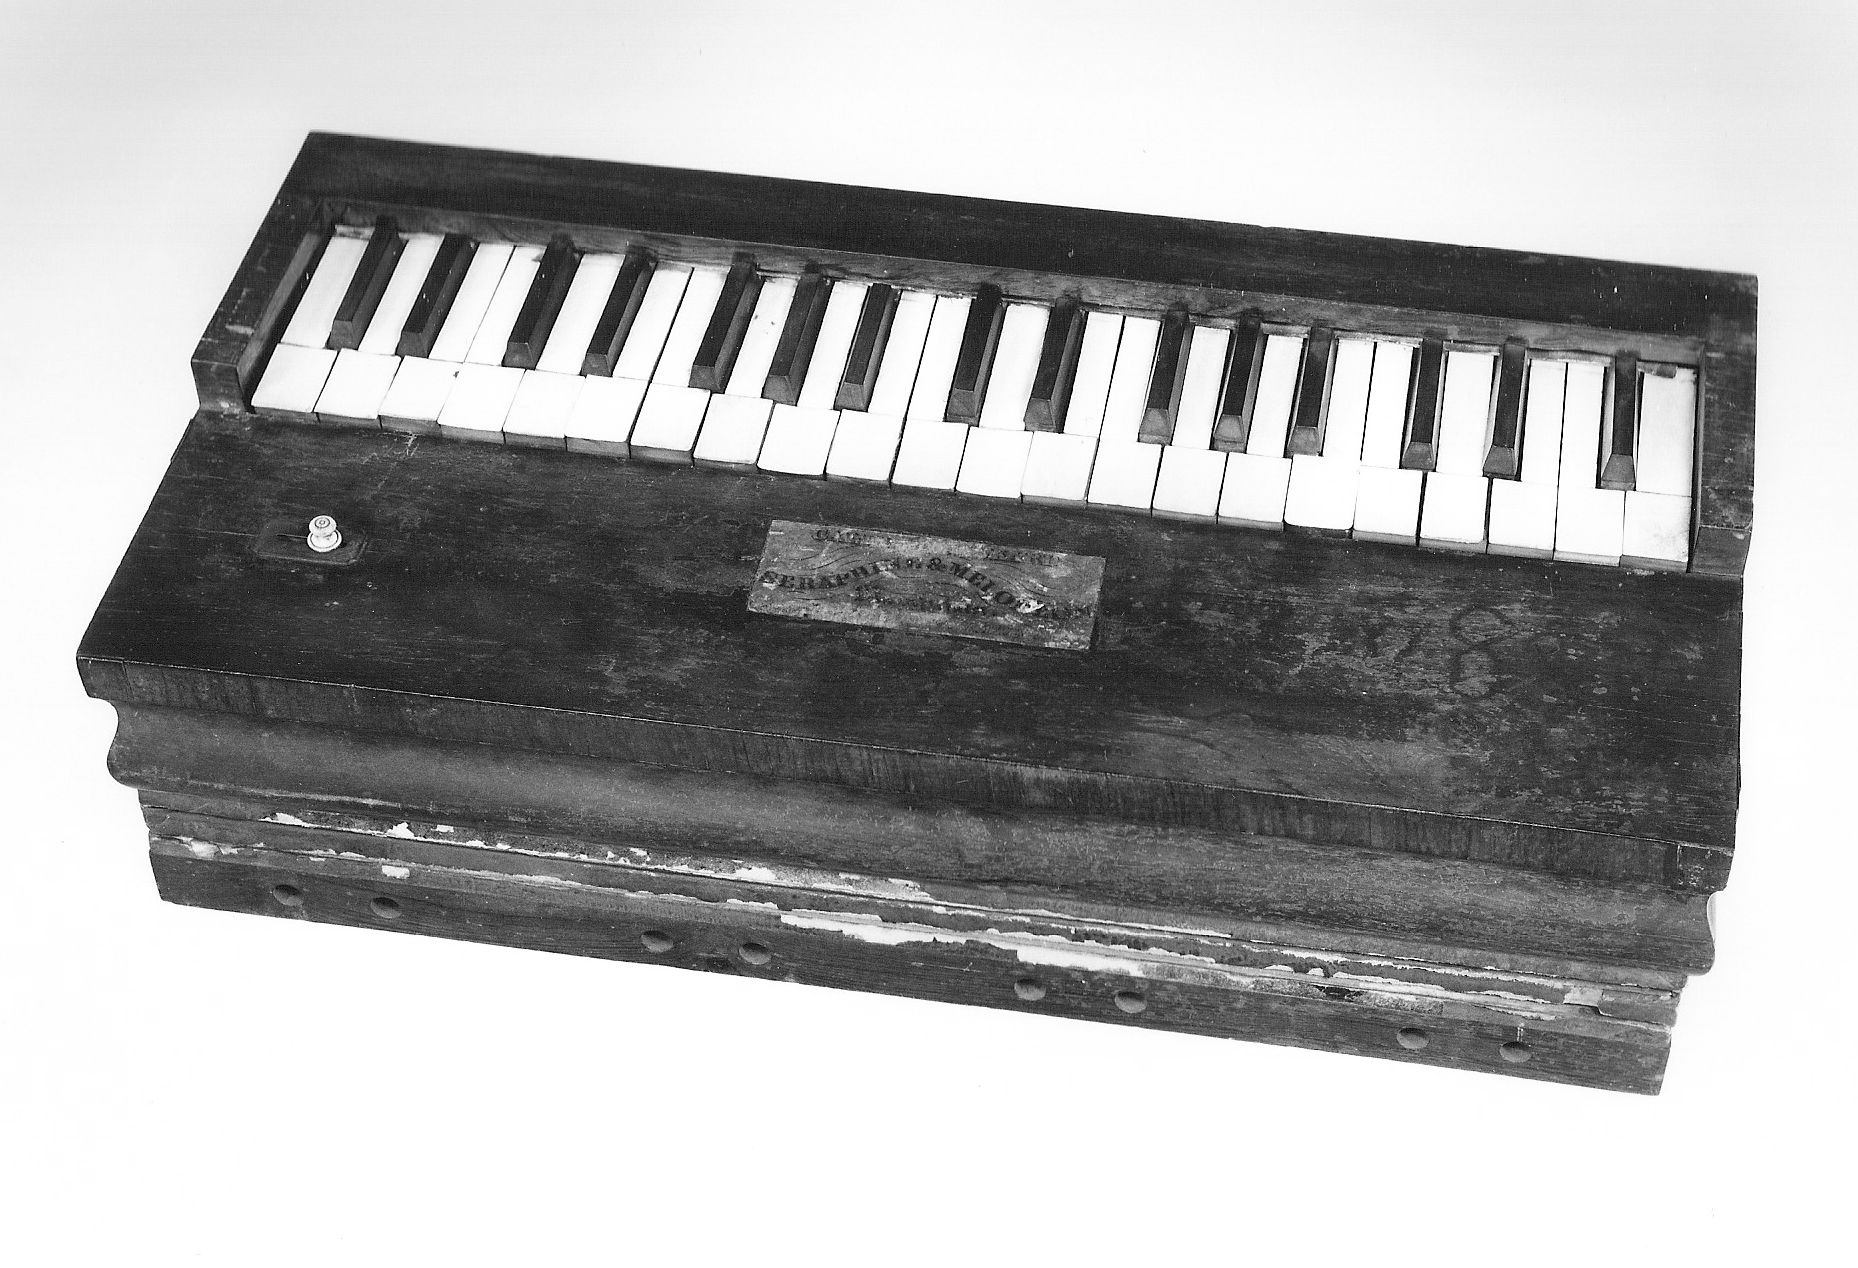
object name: rocking melodeon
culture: american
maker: caleb packard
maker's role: maker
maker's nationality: american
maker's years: 1818-1906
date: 1843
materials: wood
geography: united states